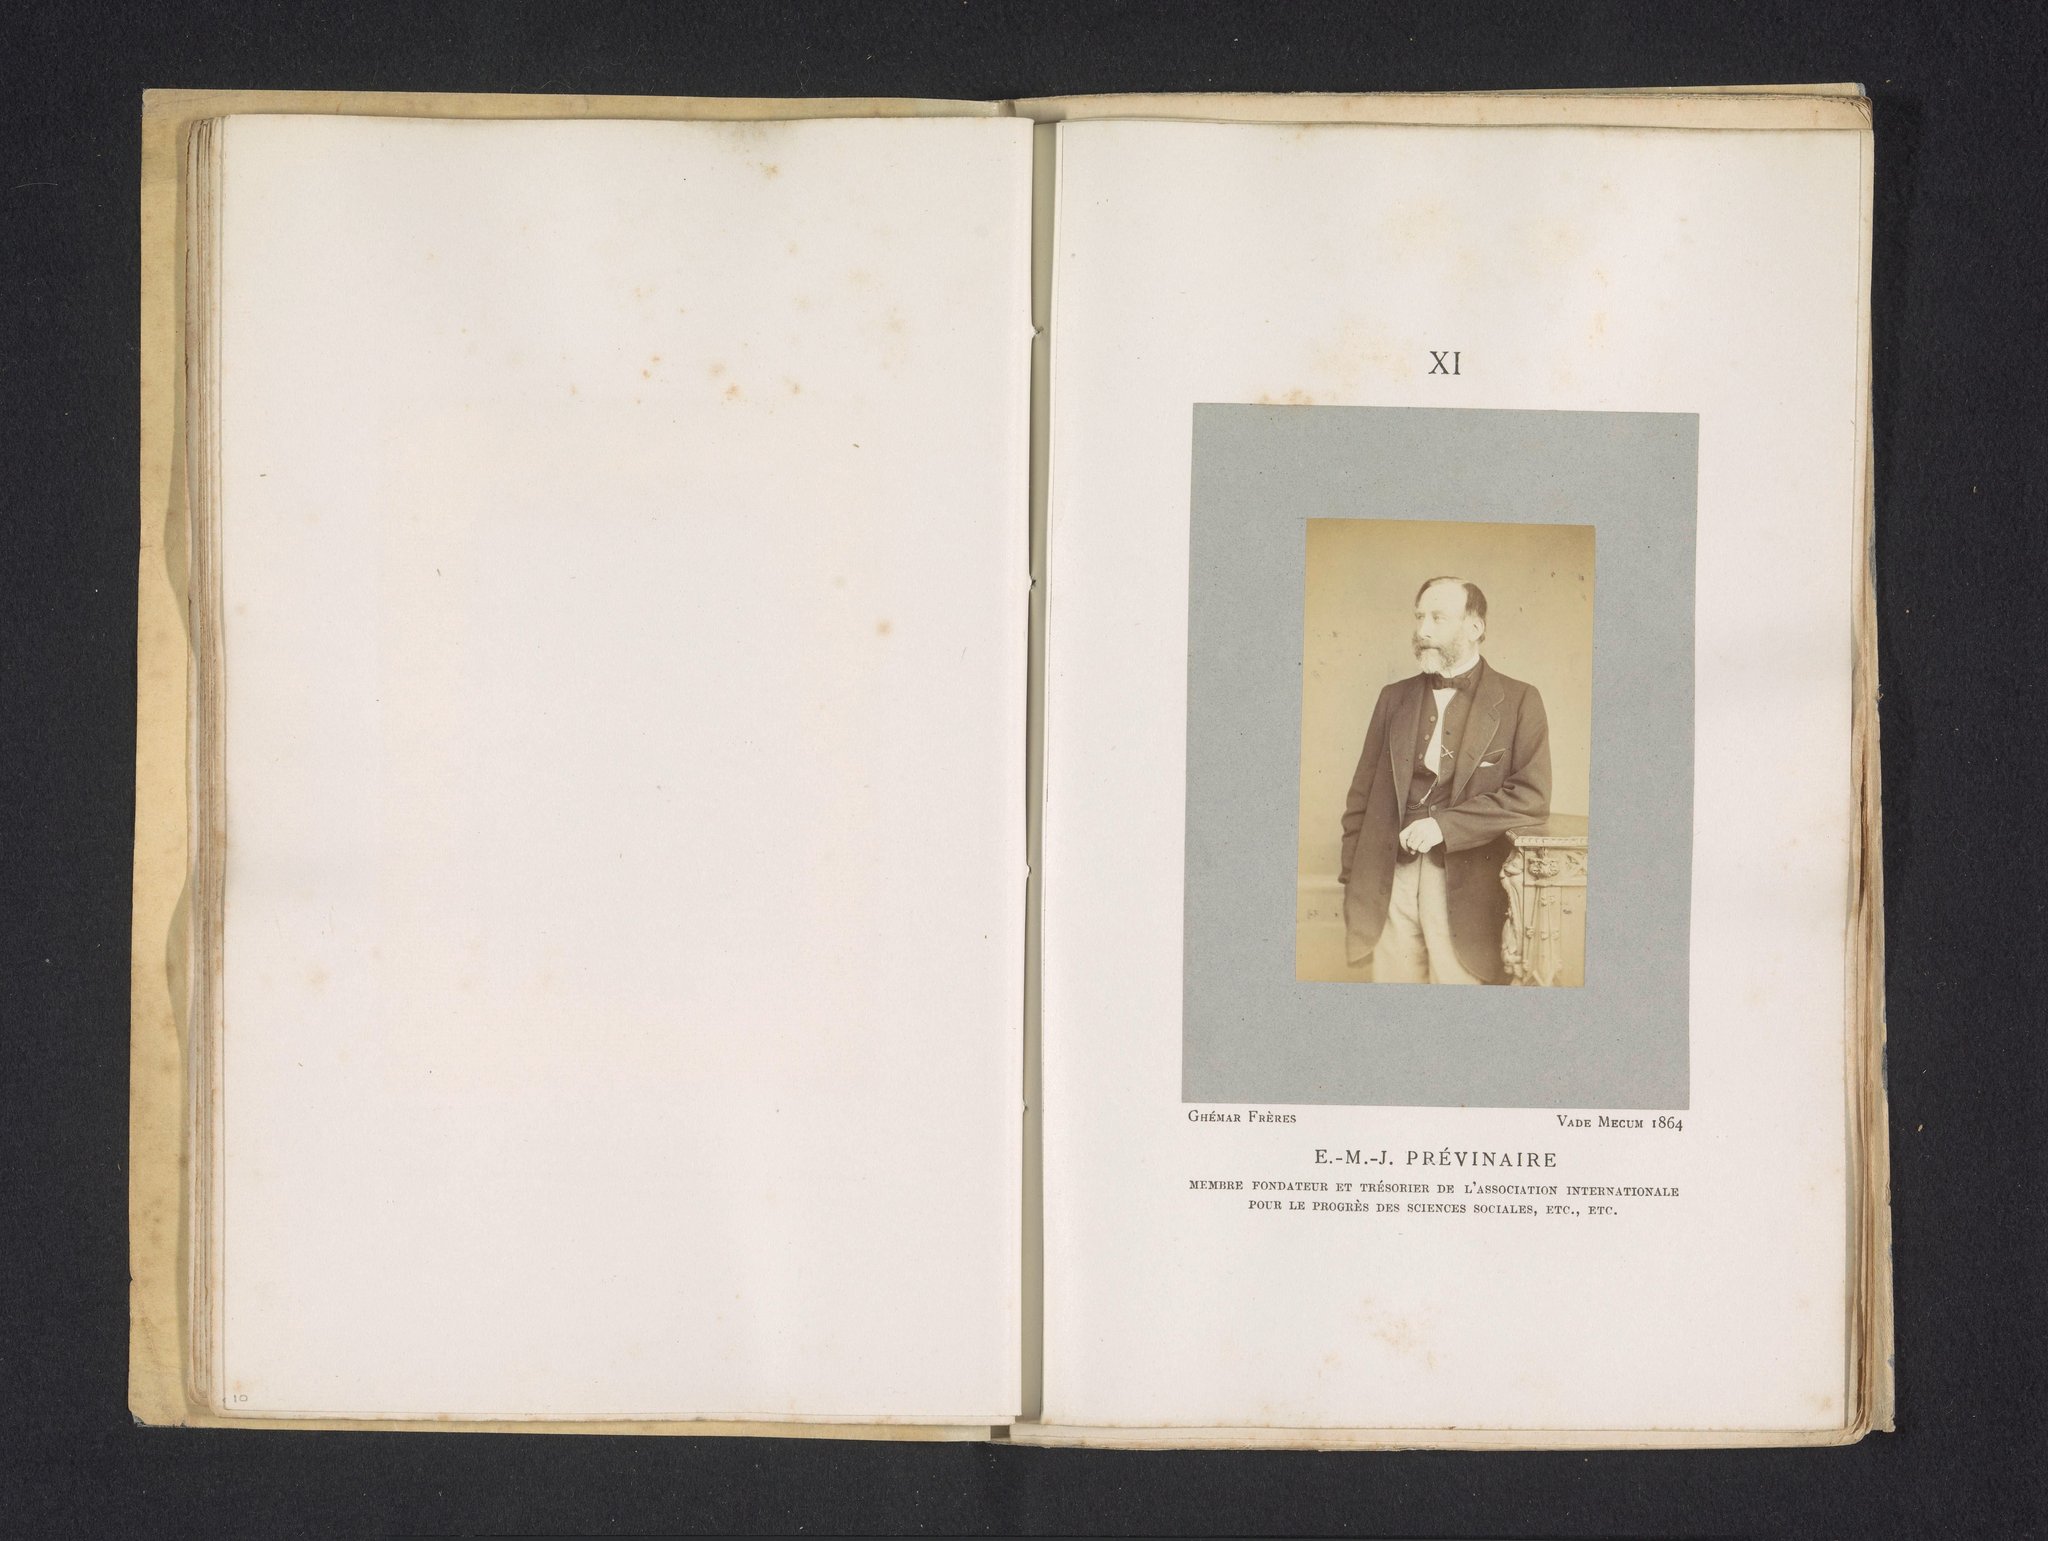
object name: photograph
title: E.-M.-J. Prévinaire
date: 1860-1865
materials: photographic support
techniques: albumen print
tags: louvain, politician, historical persons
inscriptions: inscription: ‘Vade Mecum 1864’, inscription: ‘Membre Fondateur et Trésorier de l'Association Internationale/ pour le Progrès des Sciences Sociales, etc., etc.’, number: ‘XI’